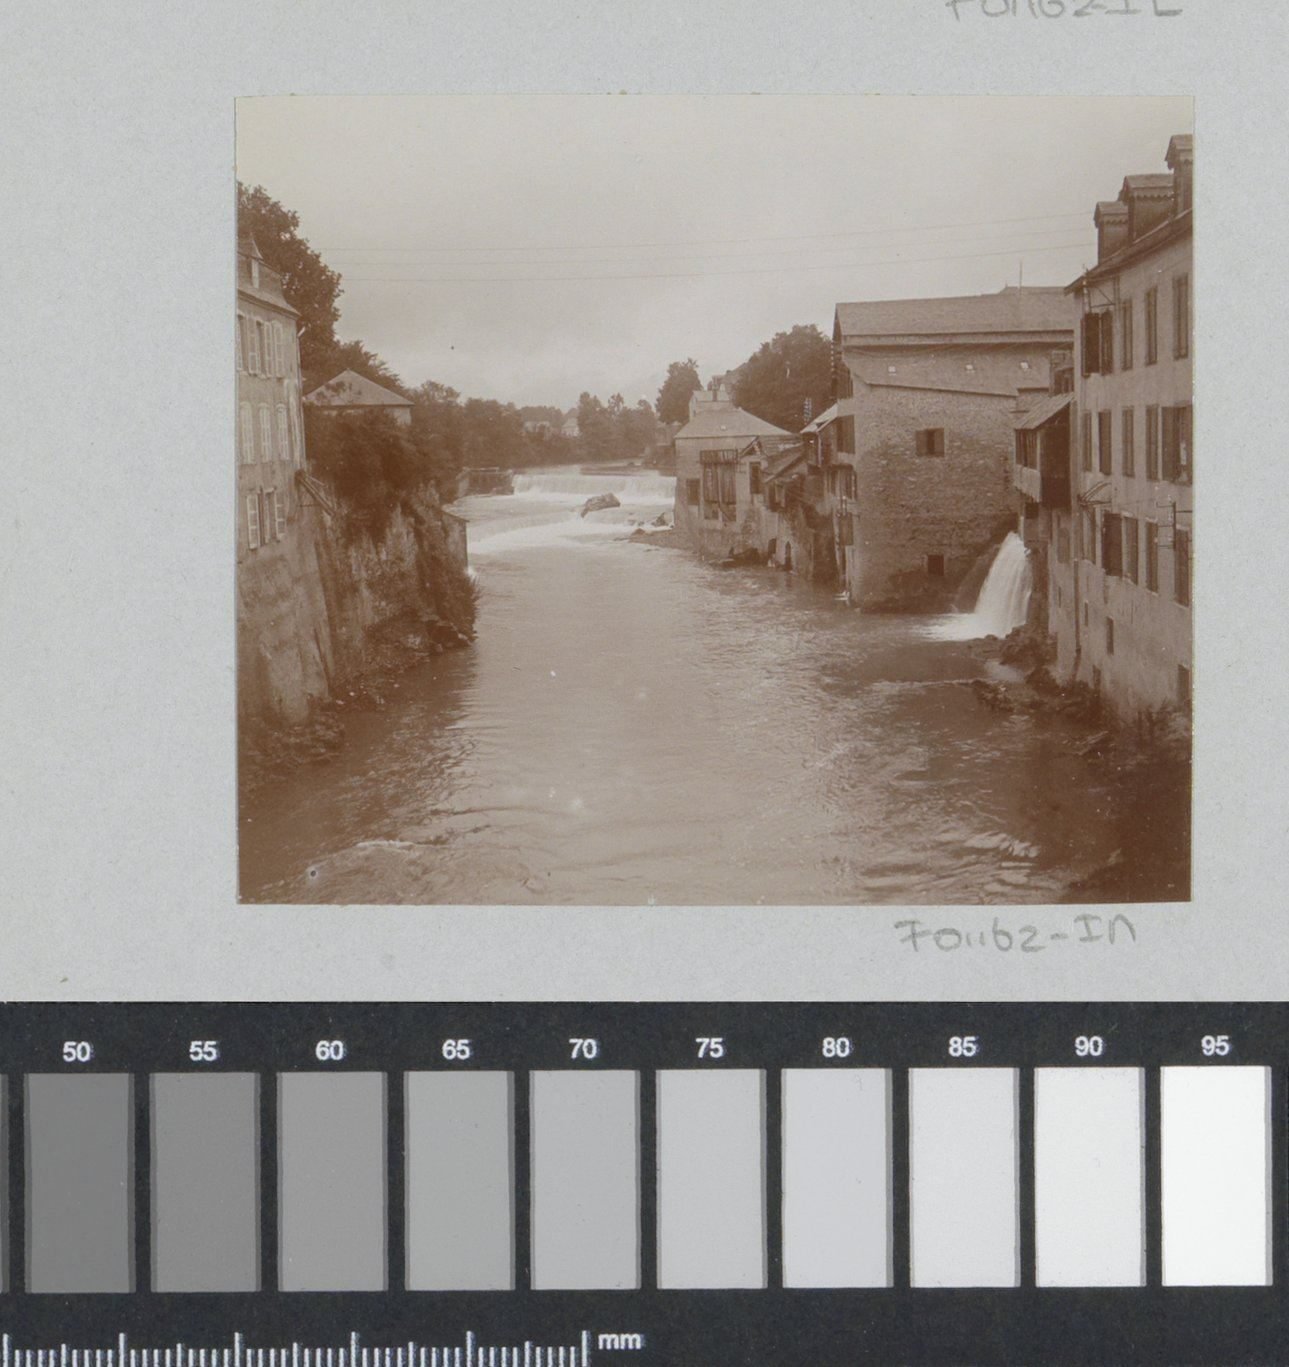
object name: photograph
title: Huizen aan een rivier met een waterval en stroomversnellingen, vermoedelijk in Frankrijk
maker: Anonymous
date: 1905-1910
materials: paper, photographic support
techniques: gelatin silver print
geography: france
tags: prospect of village, silhouette of village, rapids, river bank, waterfall, river (+ landscape with figures, staffage), france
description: Onderdeel van Fotoalbum van een Franse amateurfotograaf met bezienswaardigheden in Frankrijk, Zwitserland en Italië.